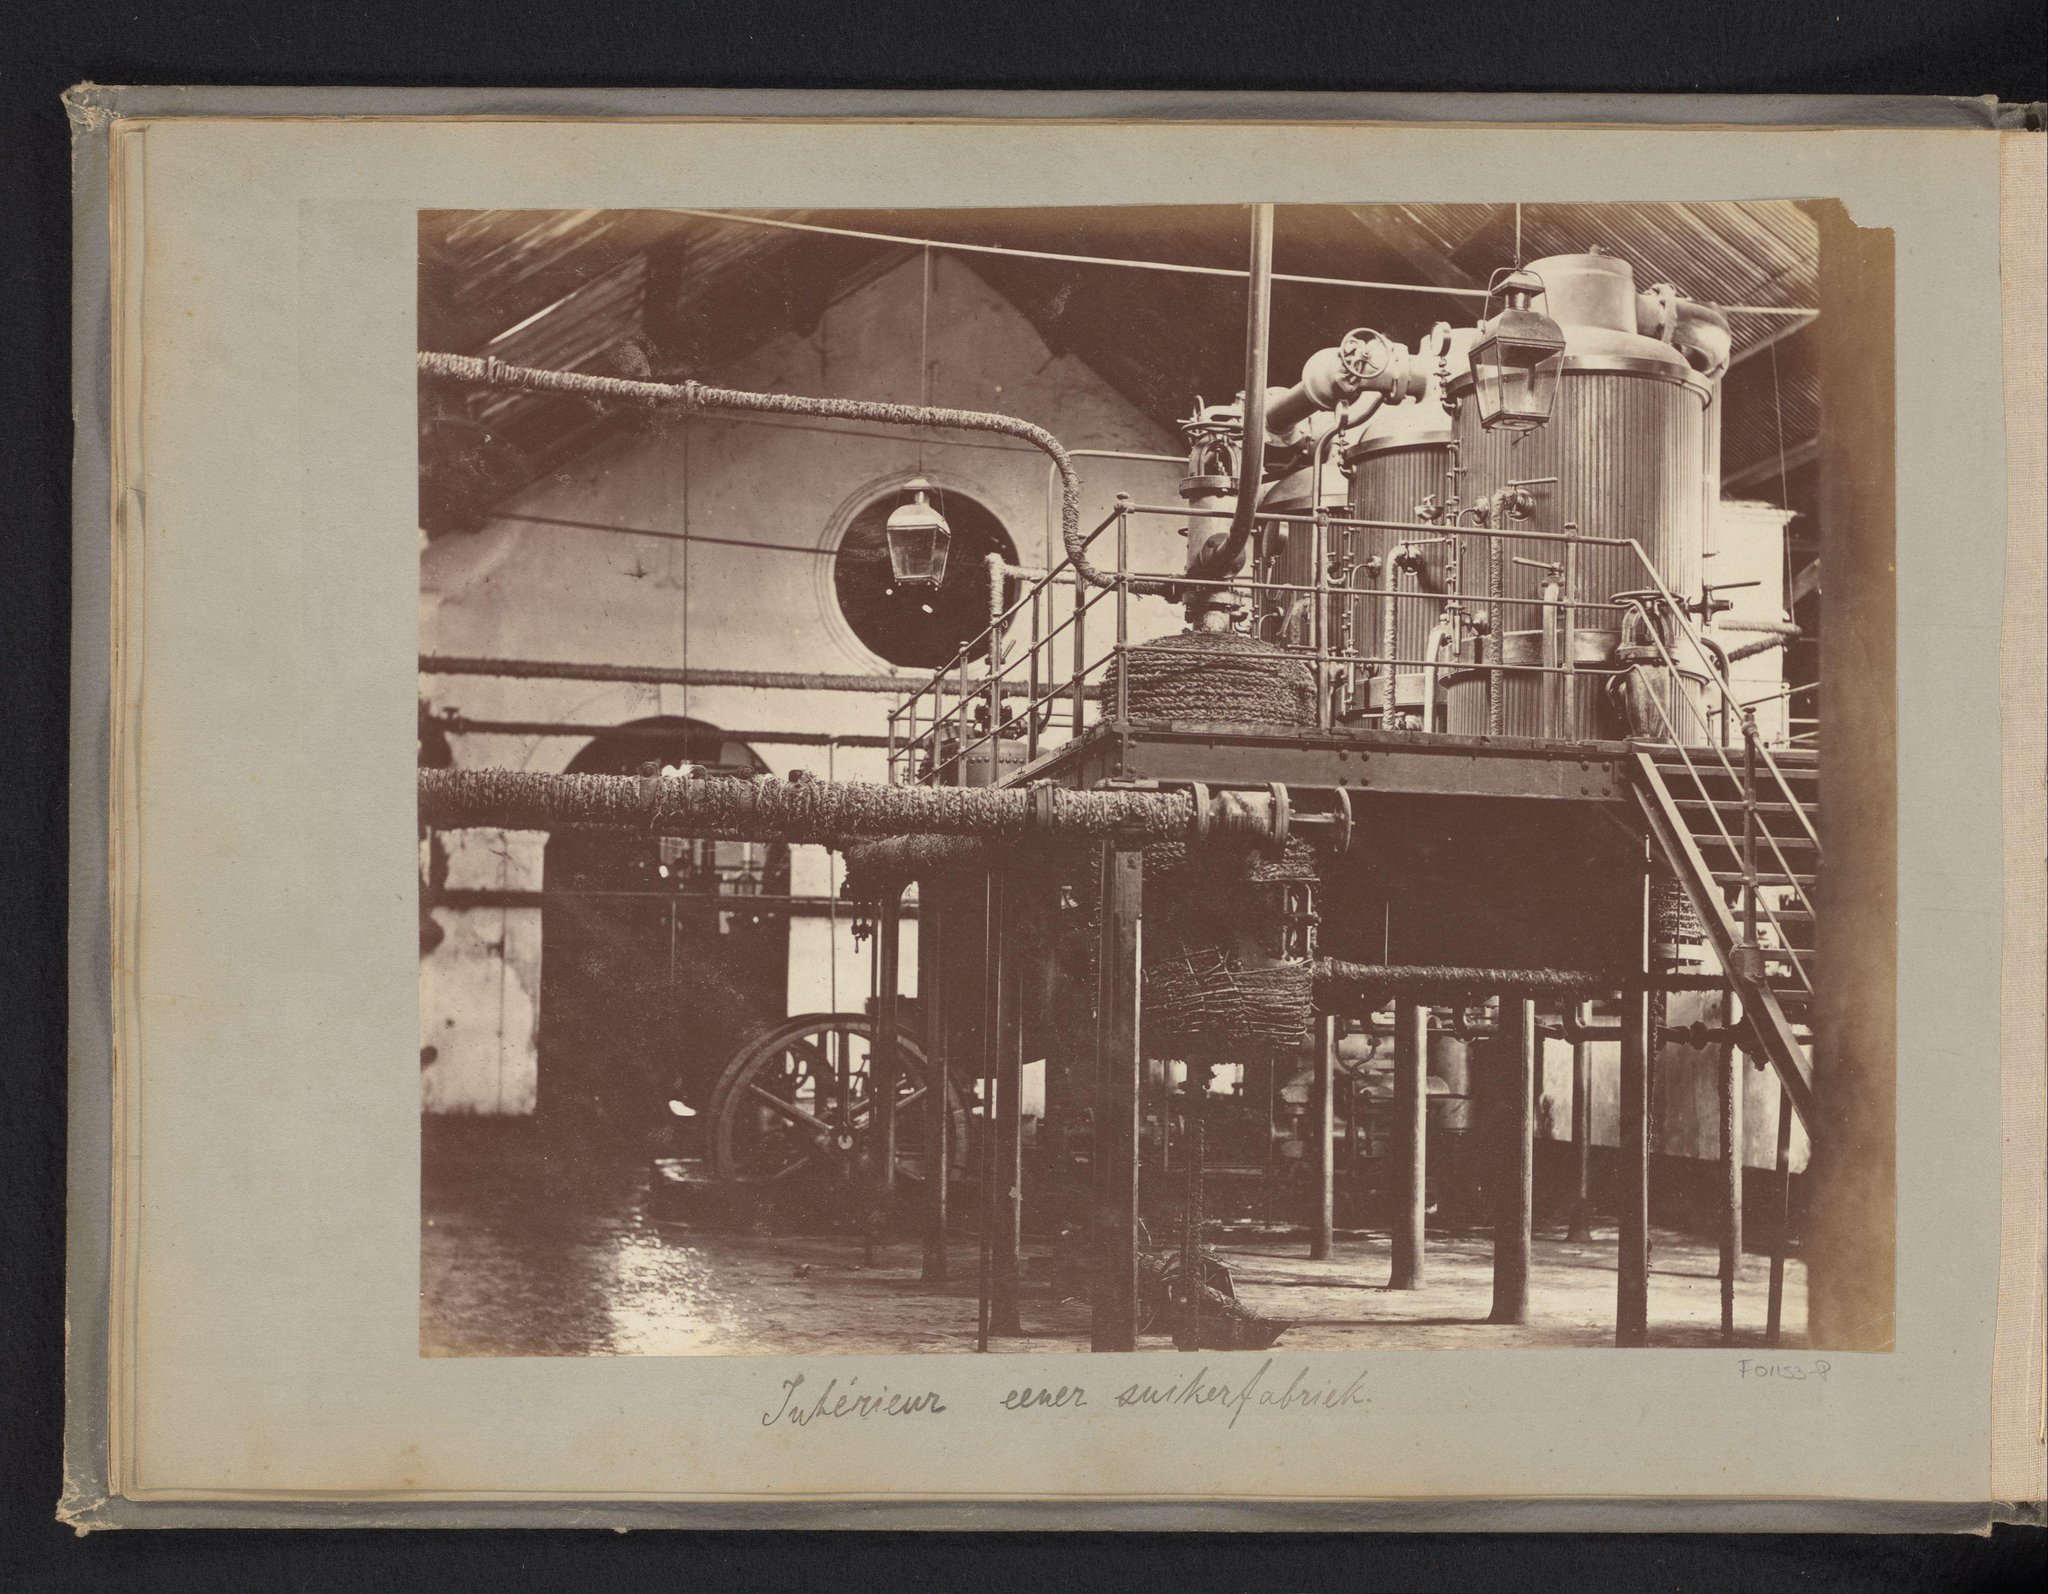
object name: album leaf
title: Interieur eener suikerfabriek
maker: Anonymous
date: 1890-1900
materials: photographic support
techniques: albumen print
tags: factory-interior, machine shop, dutch east indies, the, indonesia